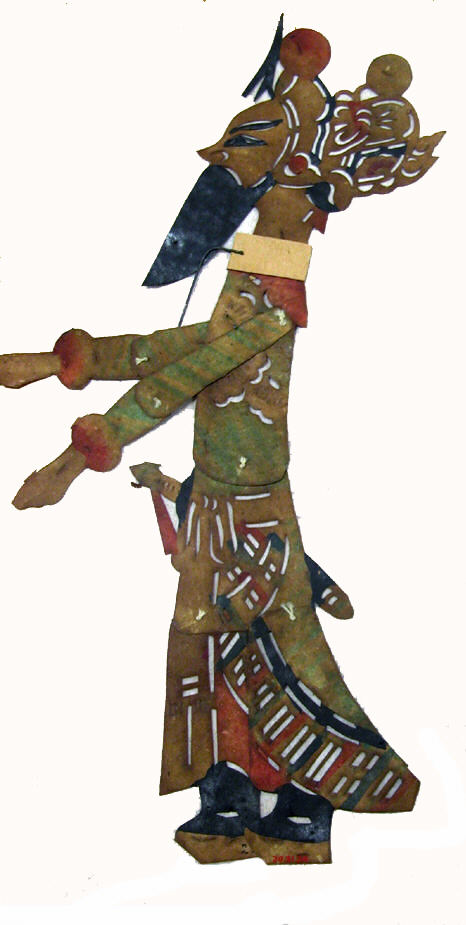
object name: shadow player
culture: chinese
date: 1801-1900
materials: cord, skin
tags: men